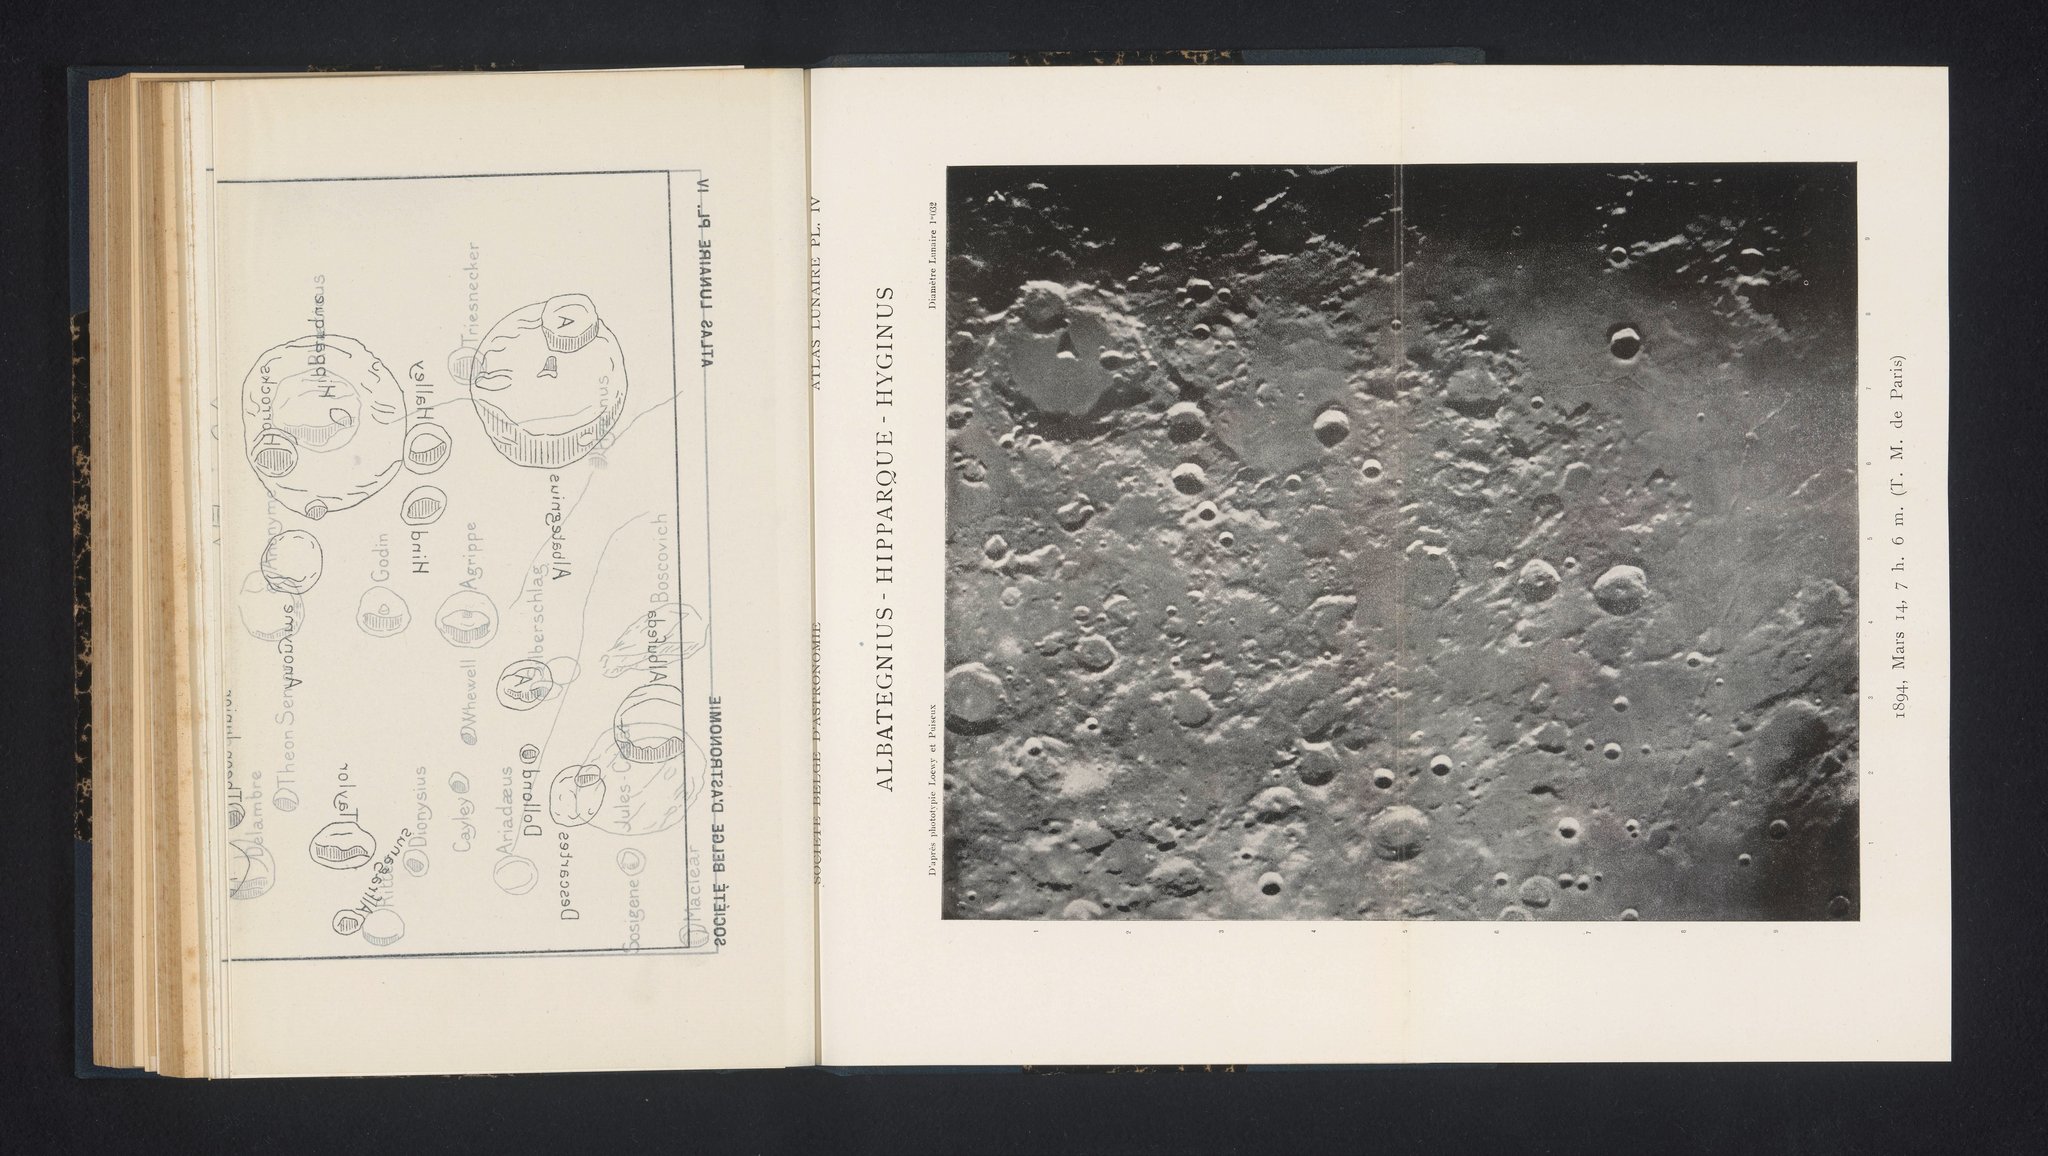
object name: photomechanical print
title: Albategnius - Hipparque - Hyginus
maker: loewy et puiseux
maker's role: fotograaf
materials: paper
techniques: autotype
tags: surface of the moon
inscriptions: inscription: ‘Société Belge d'Astronomie Atlas Lunaire Pl IV/ 1894, Mars 14. 7h, 6m. (T. M. de Paris)’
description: Transparante pagina voor prent als kaart met daarop de namen van de verschillende kraters.